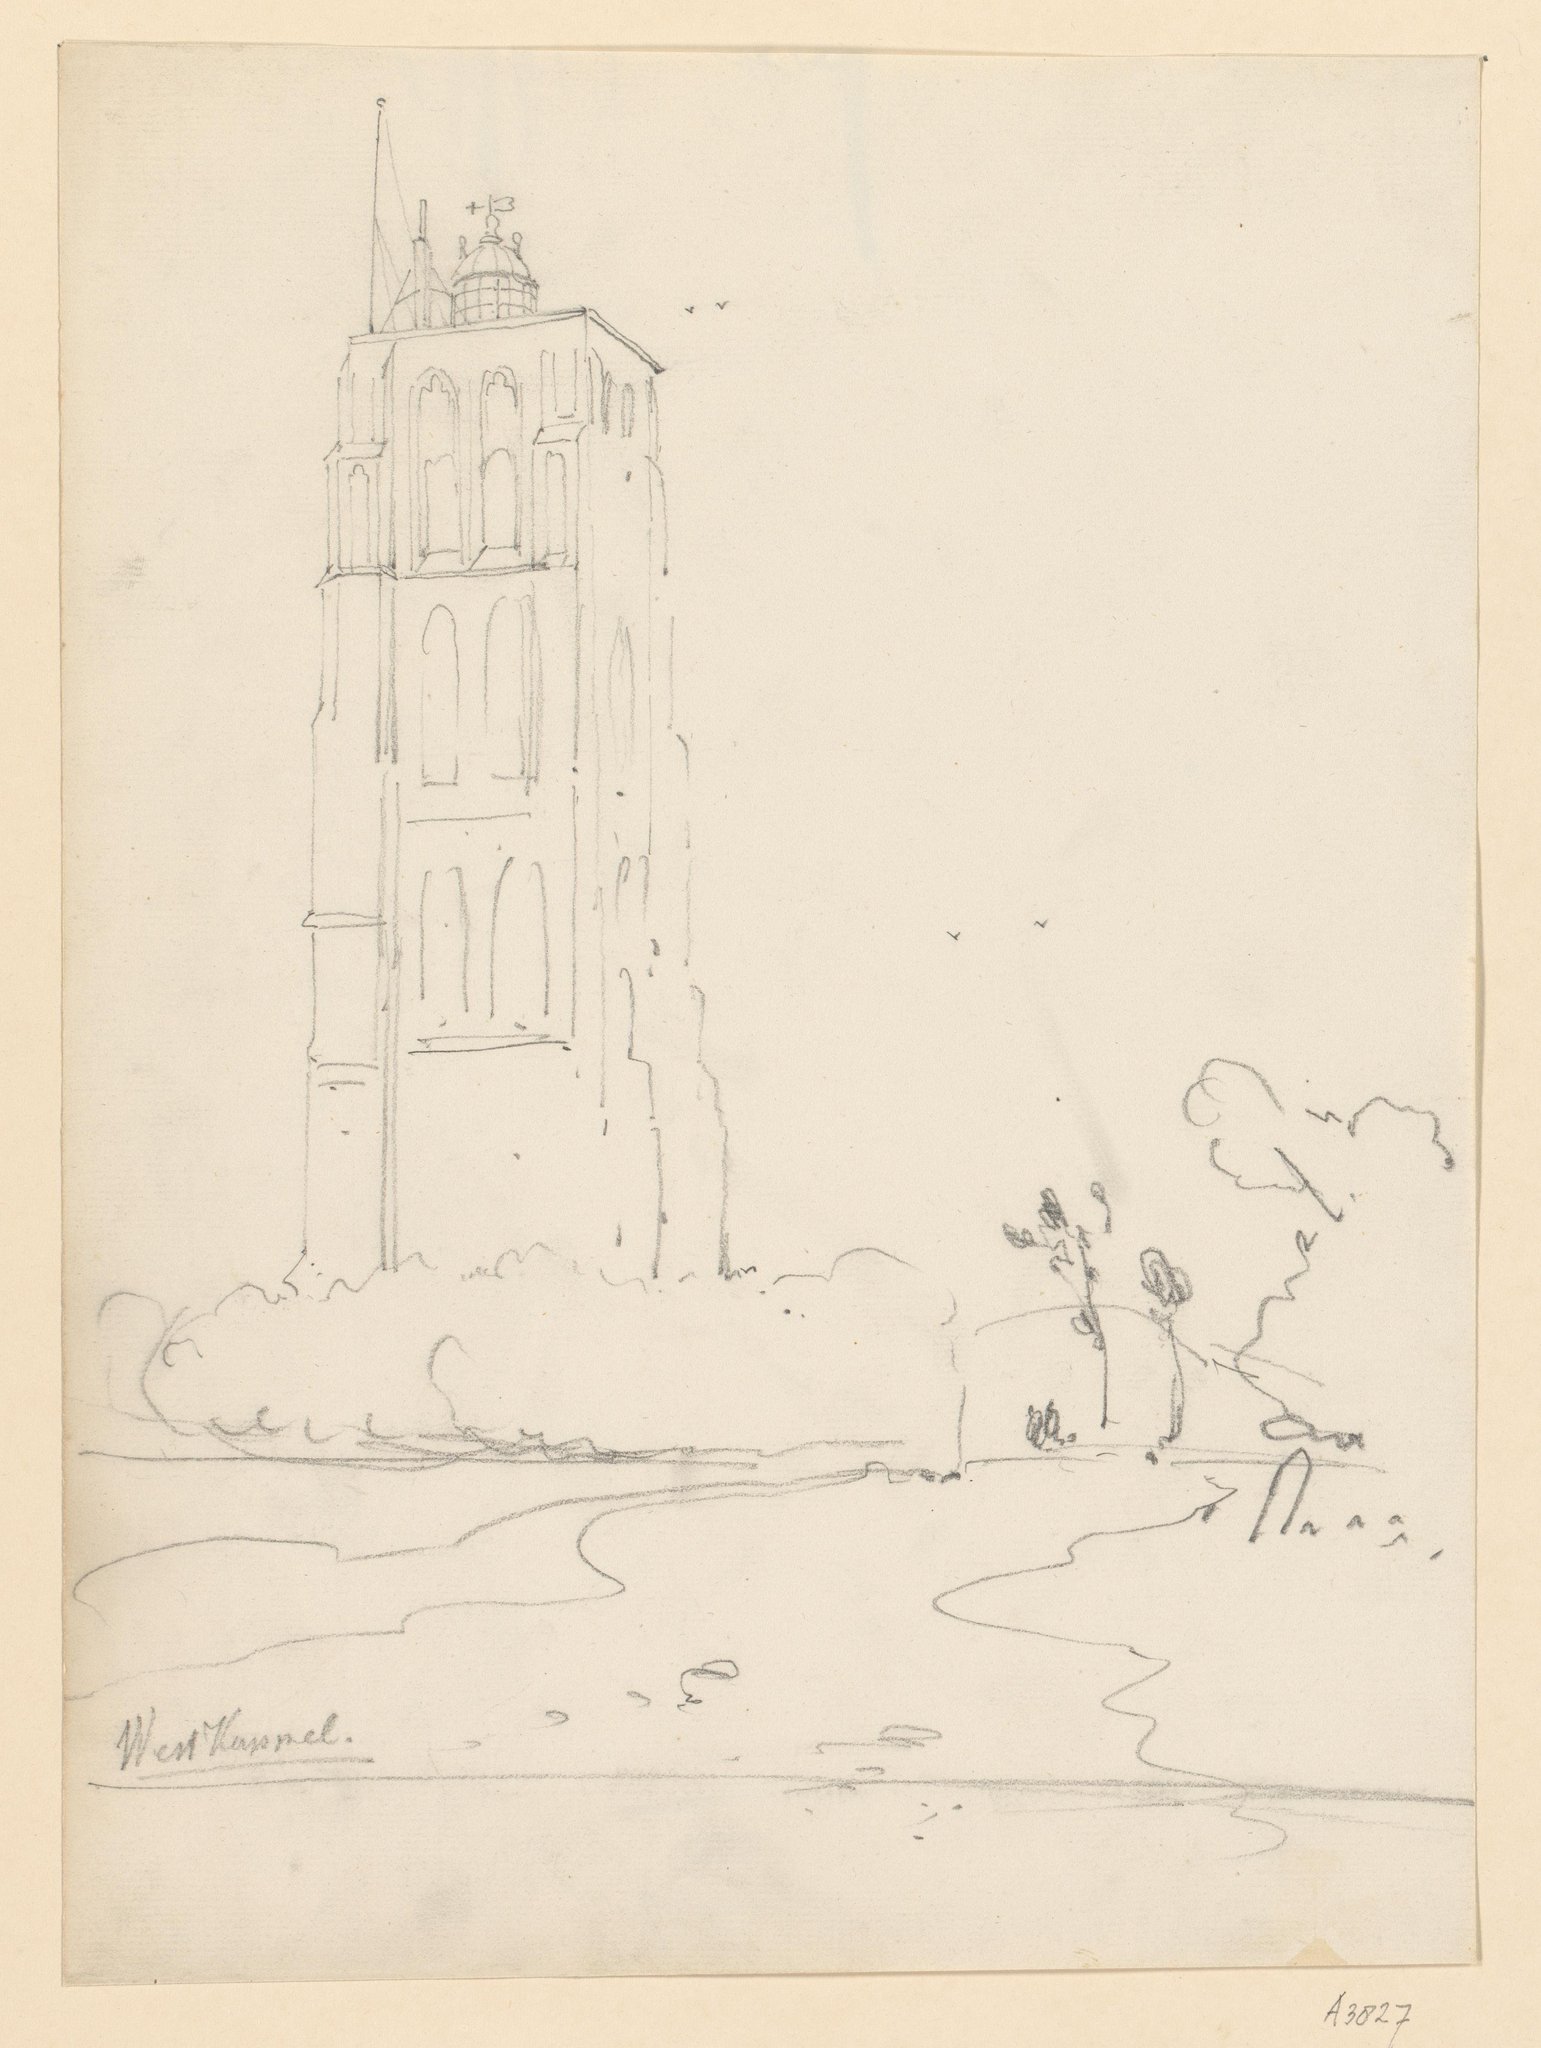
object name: drawing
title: Kerk van Westkapelle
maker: willem anthonie van deventer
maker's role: draughtsman, painter, print maker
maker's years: 1824-1893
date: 1834-1893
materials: paper, pencil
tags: church (exterior)